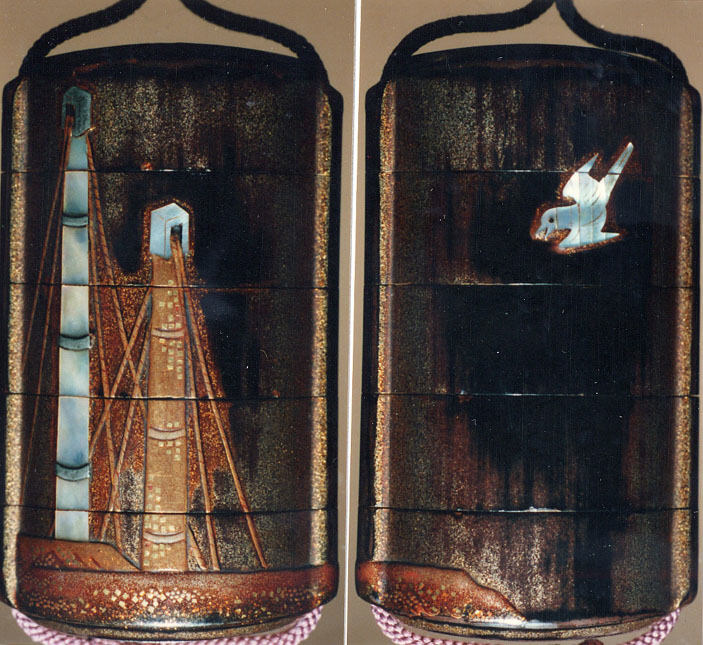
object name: inrō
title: Case (Inrō) with Design of Masts of Sailing Boats (obverse); Bird in Flight (reverse)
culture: japanese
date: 1701-1800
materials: gold, lacquer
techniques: fundame, hiramakie, inlay, roiro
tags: birds,boats